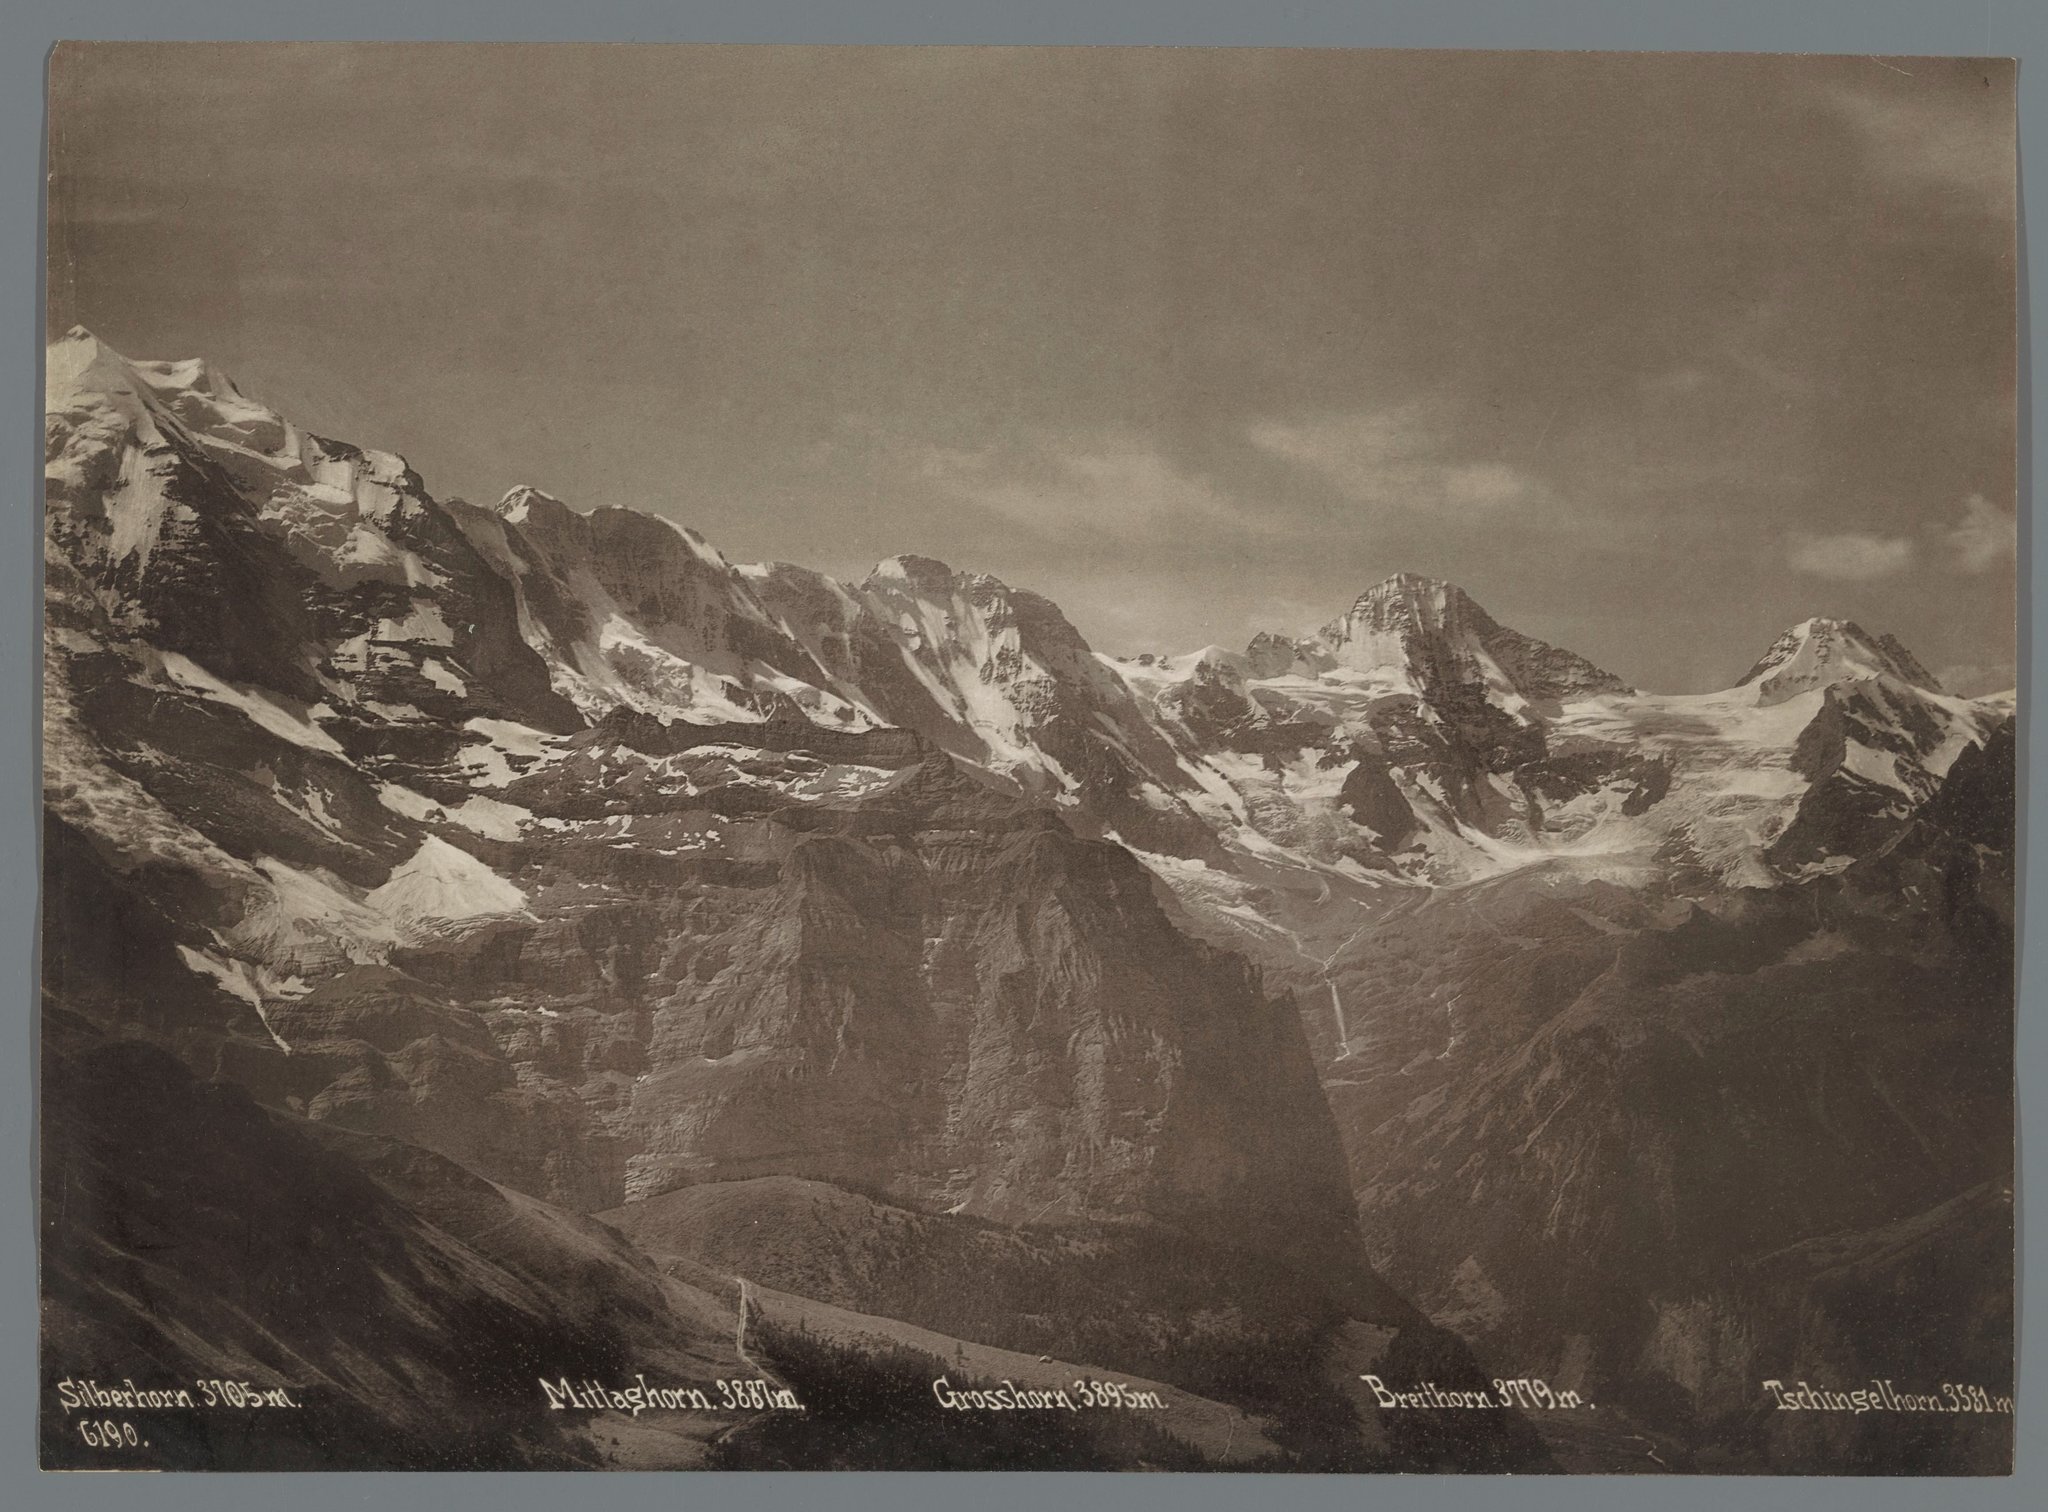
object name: photomechanical print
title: Panorama der Jungfraukette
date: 1870-1889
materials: paper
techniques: photograph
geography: berner alpen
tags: mountains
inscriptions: collector's mark: ‘VOSMAER’, inscription: ‘Silberhorn. 3705m. Mittaghorn. 3887m. Grosshorn. 3895m. Breithorn. 3779m. Tschingelhorn. 3581m’, number: ‘6190.’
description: Vormt samen met de gerelateerde objecten een panorama van de Berner Alpen.